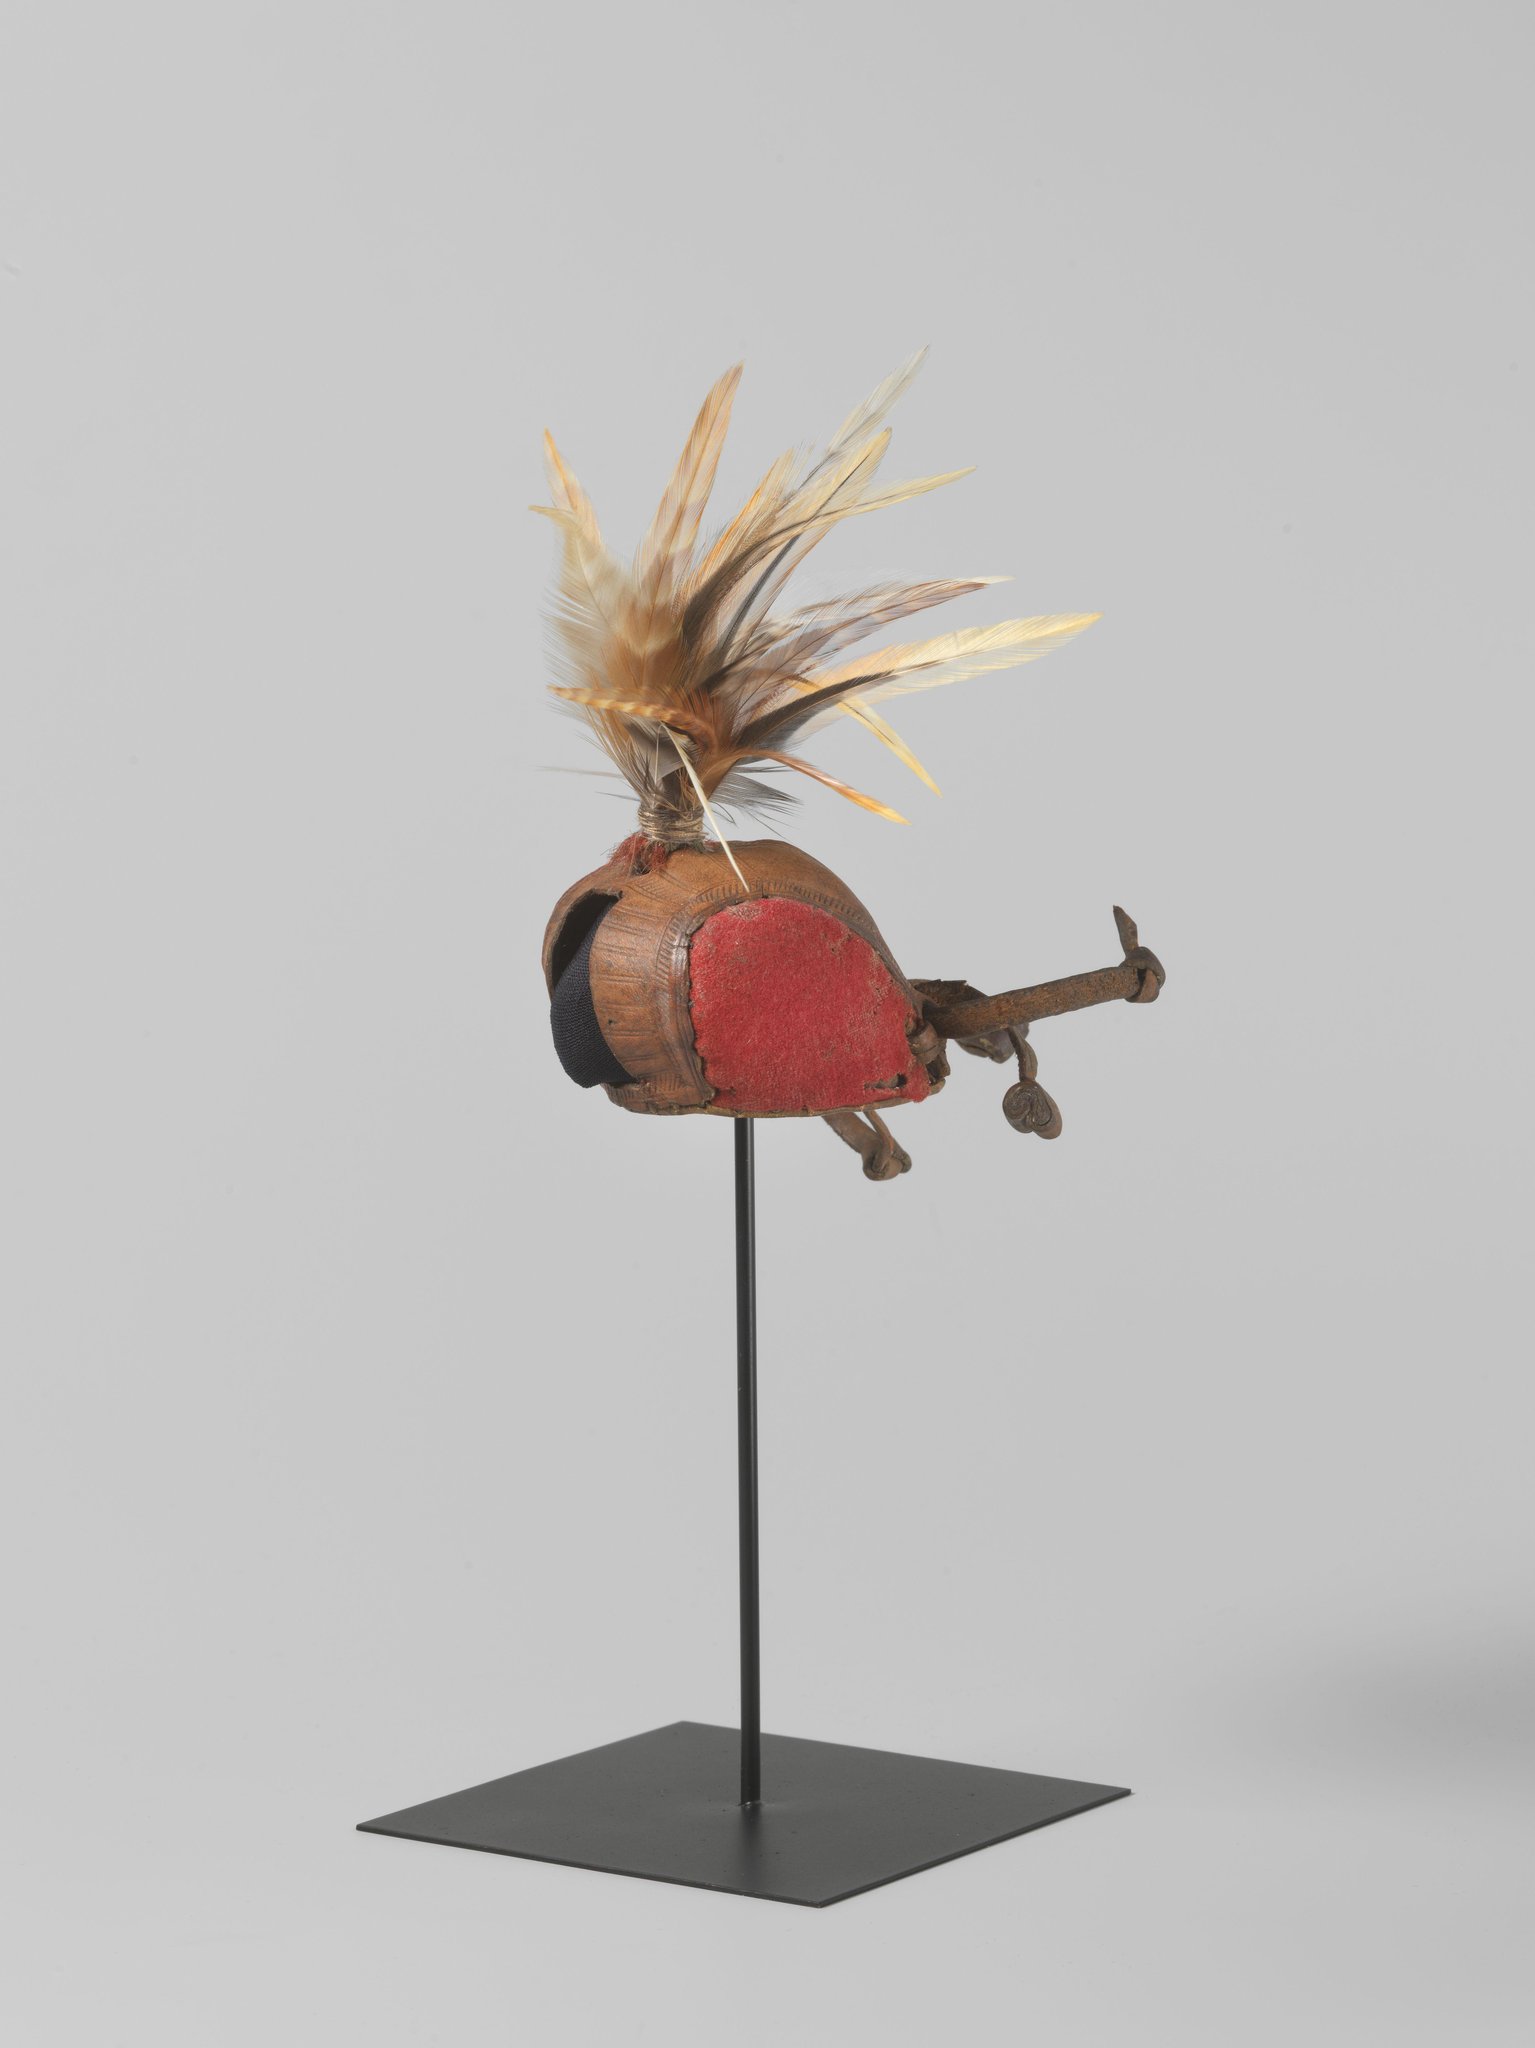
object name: falconry hood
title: Valkenkap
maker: Anonymous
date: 1400-1700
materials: textile, leather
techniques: cutting, sewing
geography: netherlands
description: Leren valkenkap met rood versierde zijkanten. Op het middenstuk is een streepversiering aangebracht. De verschillende stukken zijn met touw aan elkaar gezet. Aan de voorkant is er een opening voor de snavel; aan de achterkant zitten twee riempjes voor aantrekken van het kapje. Op de bovenkant is de aanzet voor een verenpluim.